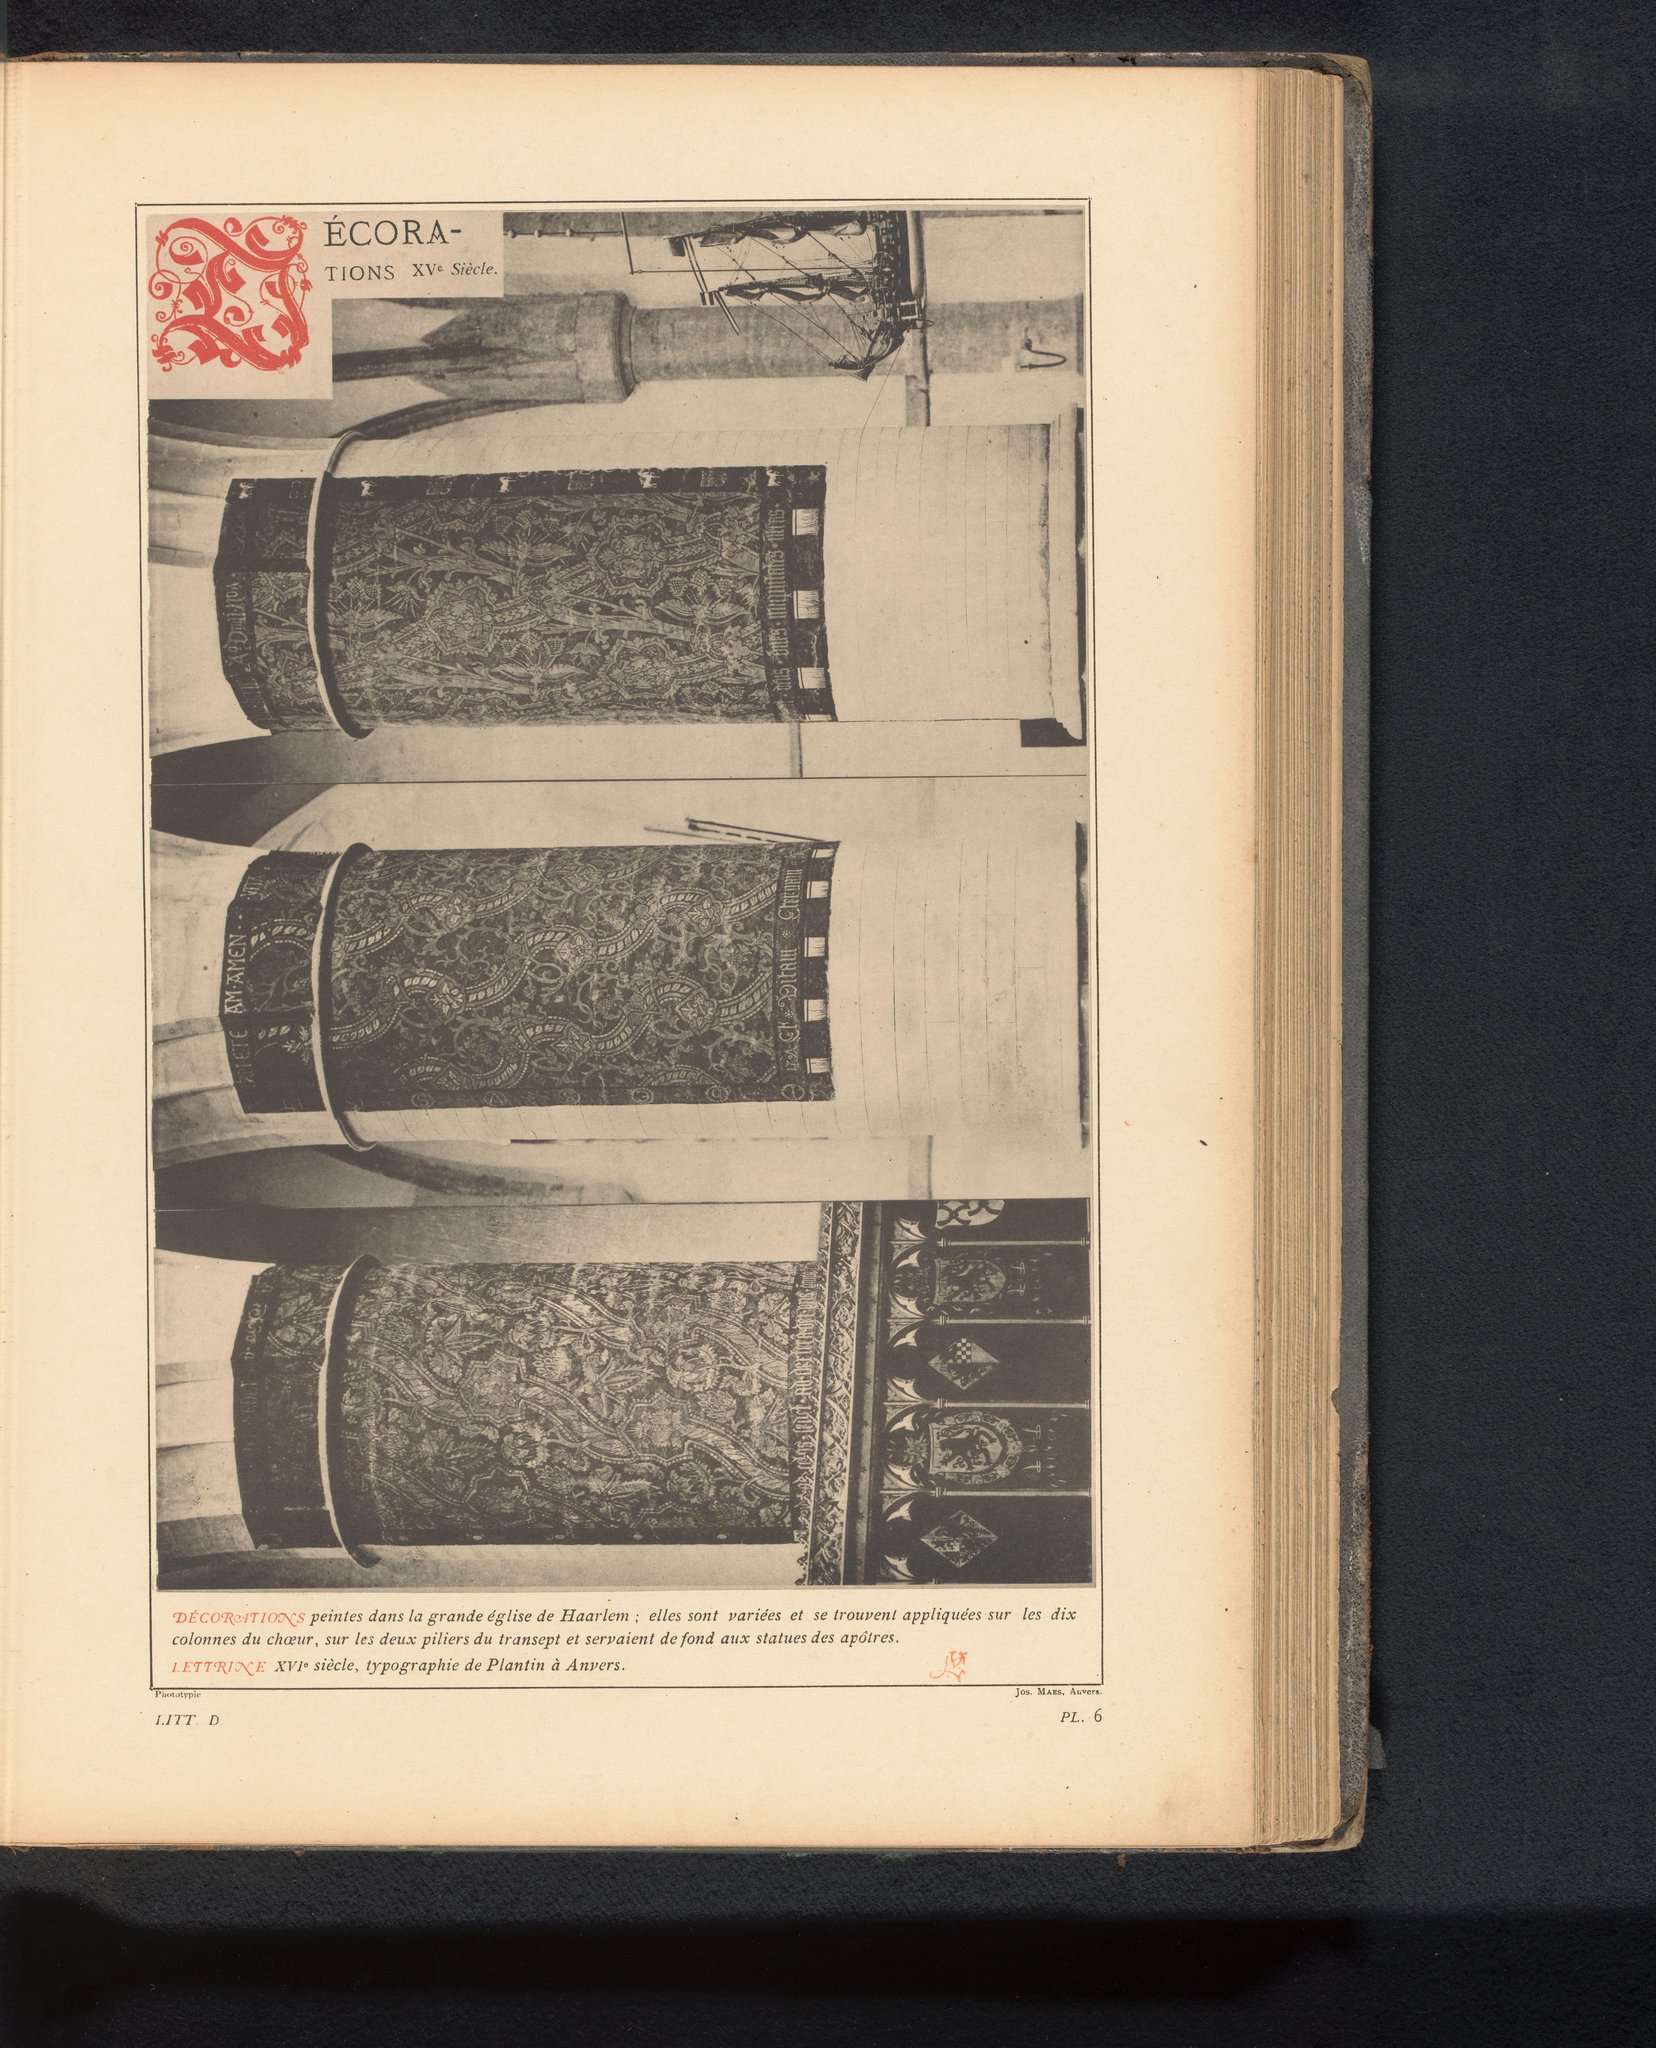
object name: page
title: Décorations, XVe Siècle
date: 1875-1880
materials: paper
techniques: photograph, photolithography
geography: haarlem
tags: column, pillar ~ architecture, interior of church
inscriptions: monogram: ‘JJvY’, inscription: ‘DÉCORATIONS peintes dans (...)’, inscription: ‘LITT. D. - PL. 6’